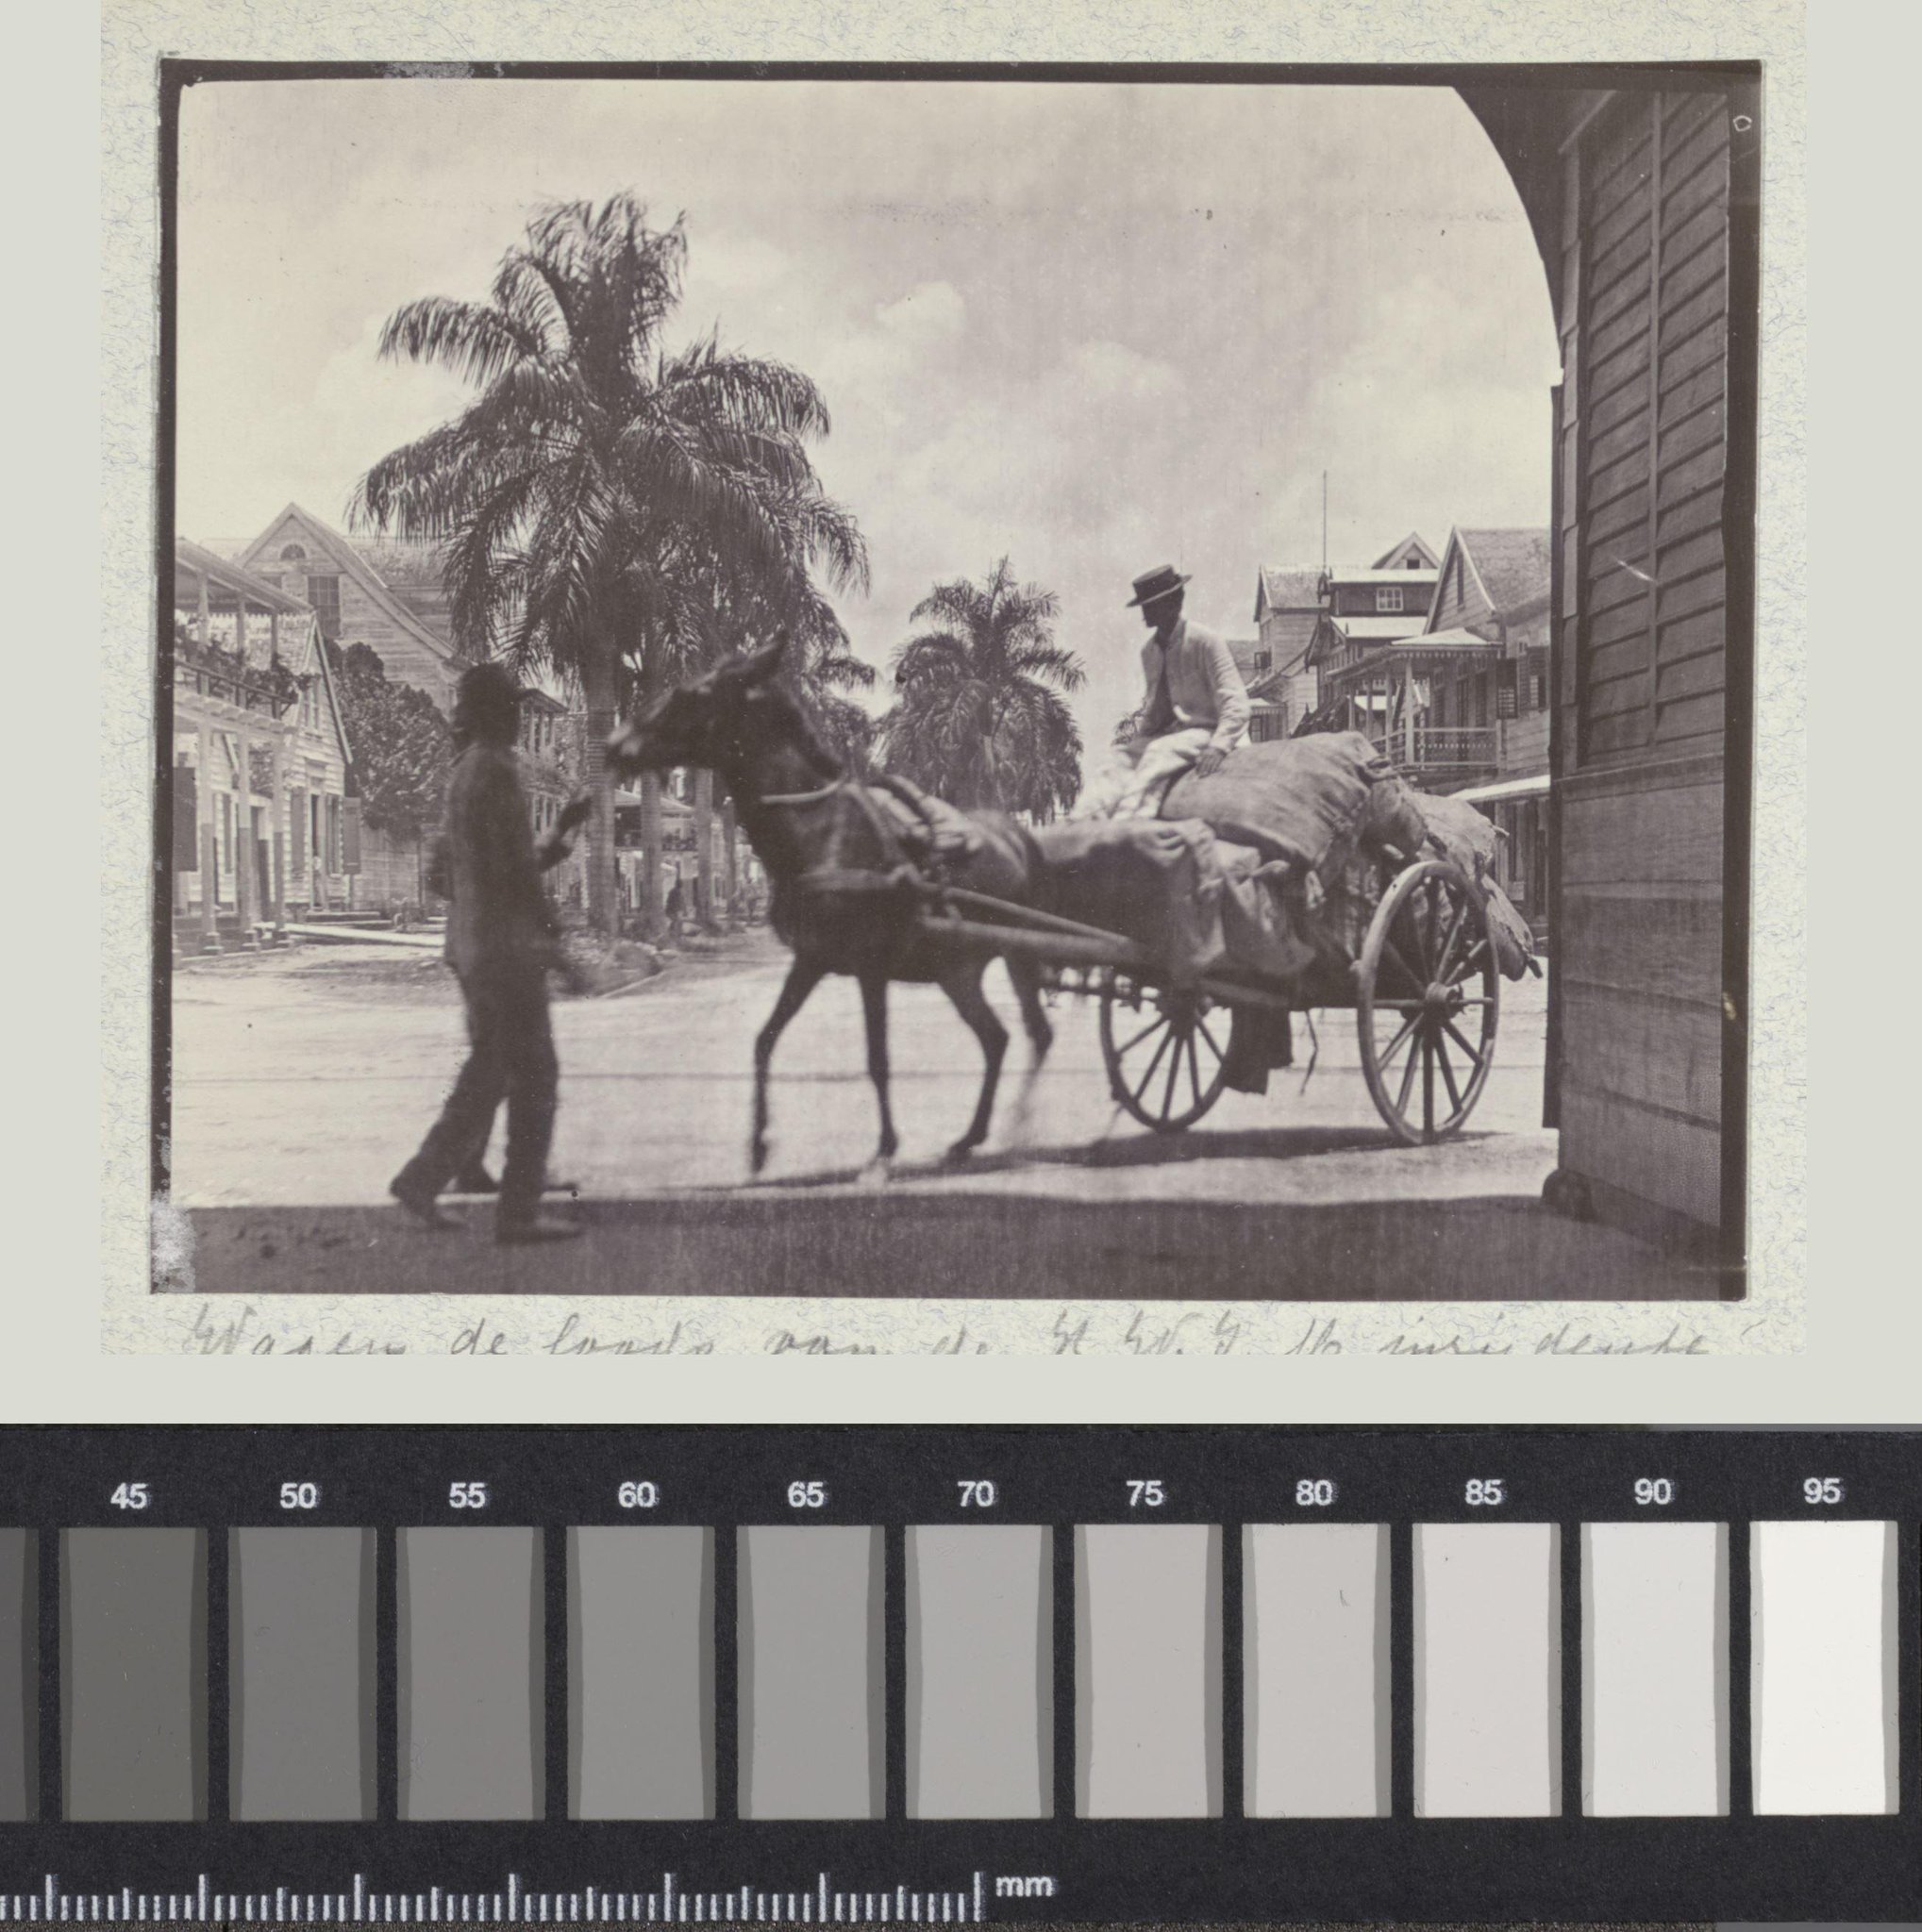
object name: photograph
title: Wagen bij de loods van de KWIM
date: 1908-1910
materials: photographic support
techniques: photography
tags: warehouse (~ harbour)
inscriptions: inscription: ‘Wagen de loods van de K.W.I.M. inrijdende. / Joden Breestraat. Oct. 1908’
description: Gezicht op een paard en wagen voor de ingang naar de loods van de KWIM in de Jodenbreestraat te Paramaribo, oktober 1908. Onderdeel van het fotoalbum van de familie Boom-Gonggrijp in Suriname en Curaçao.